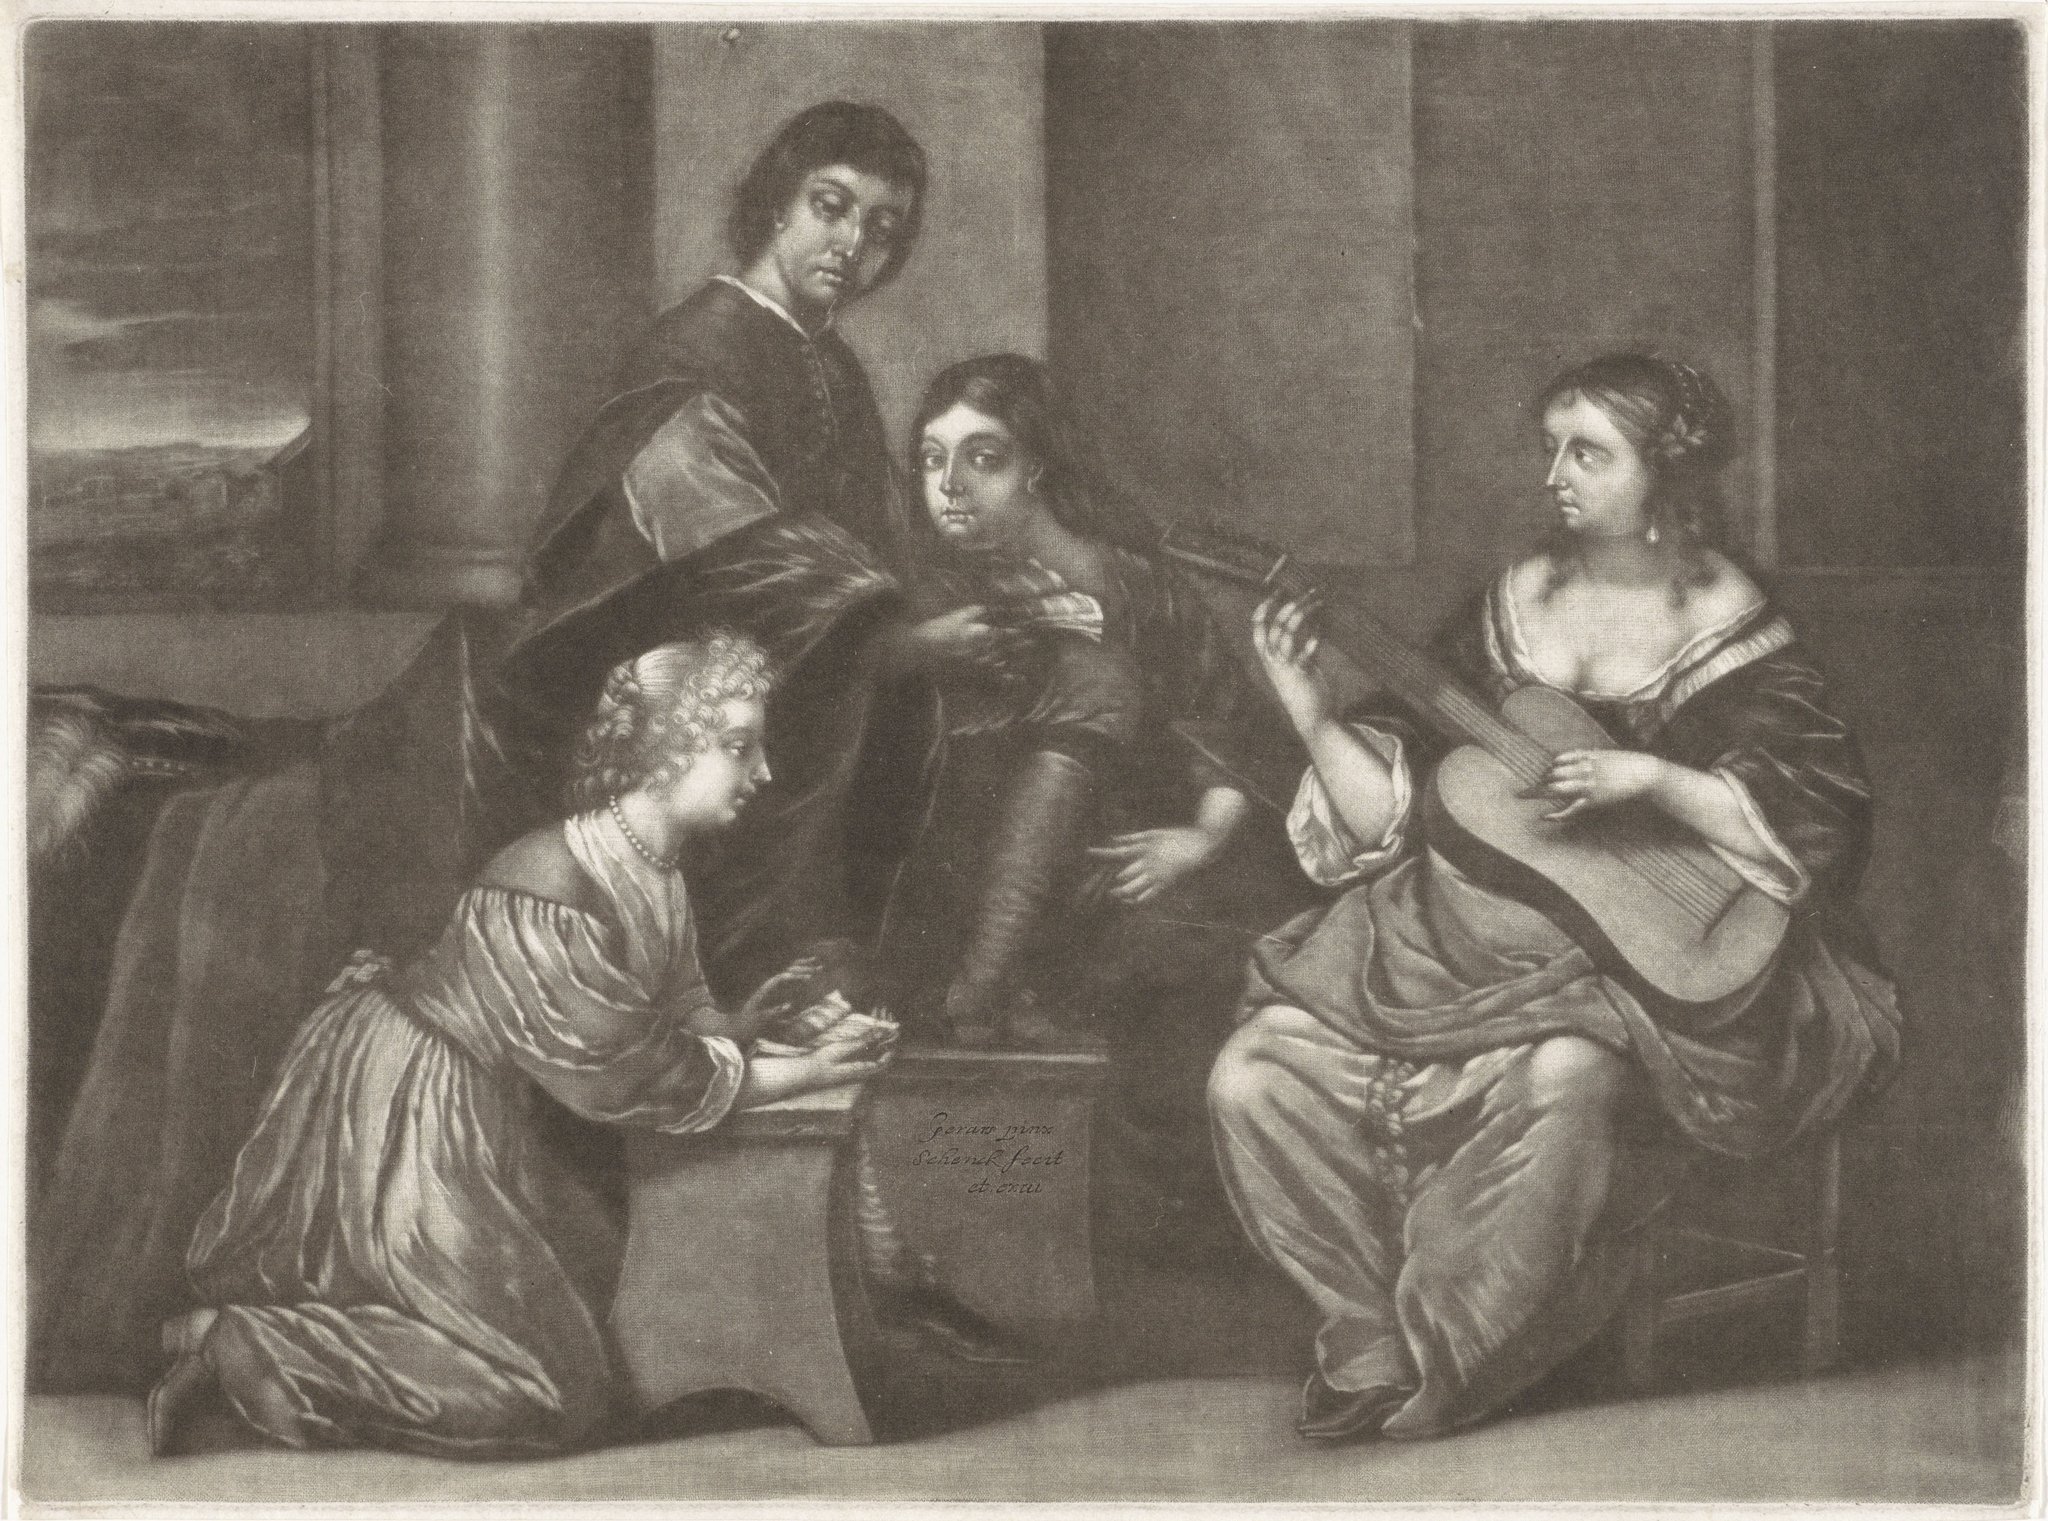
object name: print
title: Musicerend gezelschap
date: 1670-1713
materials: paper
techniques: engraving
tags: instrumental and vocal music together, cithern, mandolin, guitar, balalaika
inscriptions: collector's mark: Lugt 2166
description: Op een terras zingt een geknielde vrouw uit een liedboek, een staande man kijkt op haar neer. Ze wordt begeleid door een gitaarspeelster.